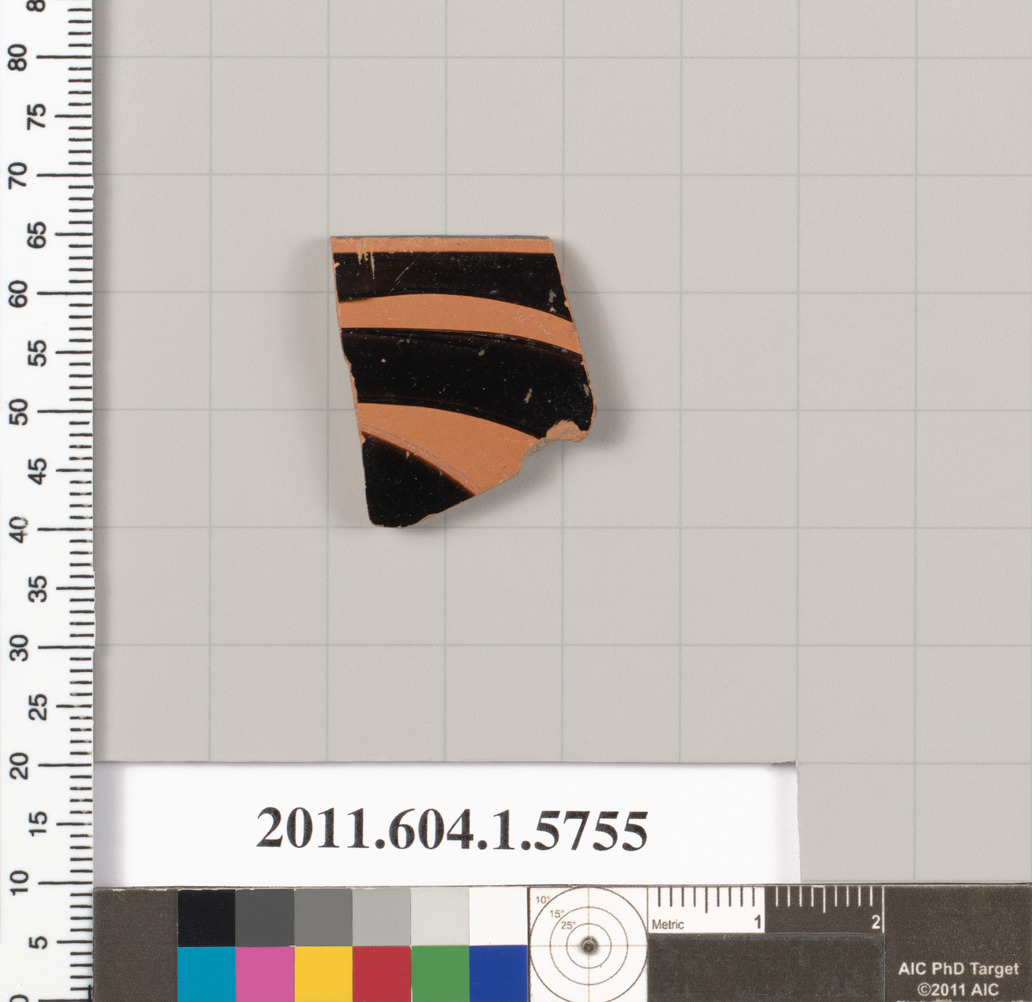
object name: kylix fragment, eye cup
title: Terracotta rim fragment of a kylix: eye-cup (drinking cup)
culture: greek, attic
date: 525-510 BCE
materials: terracotta